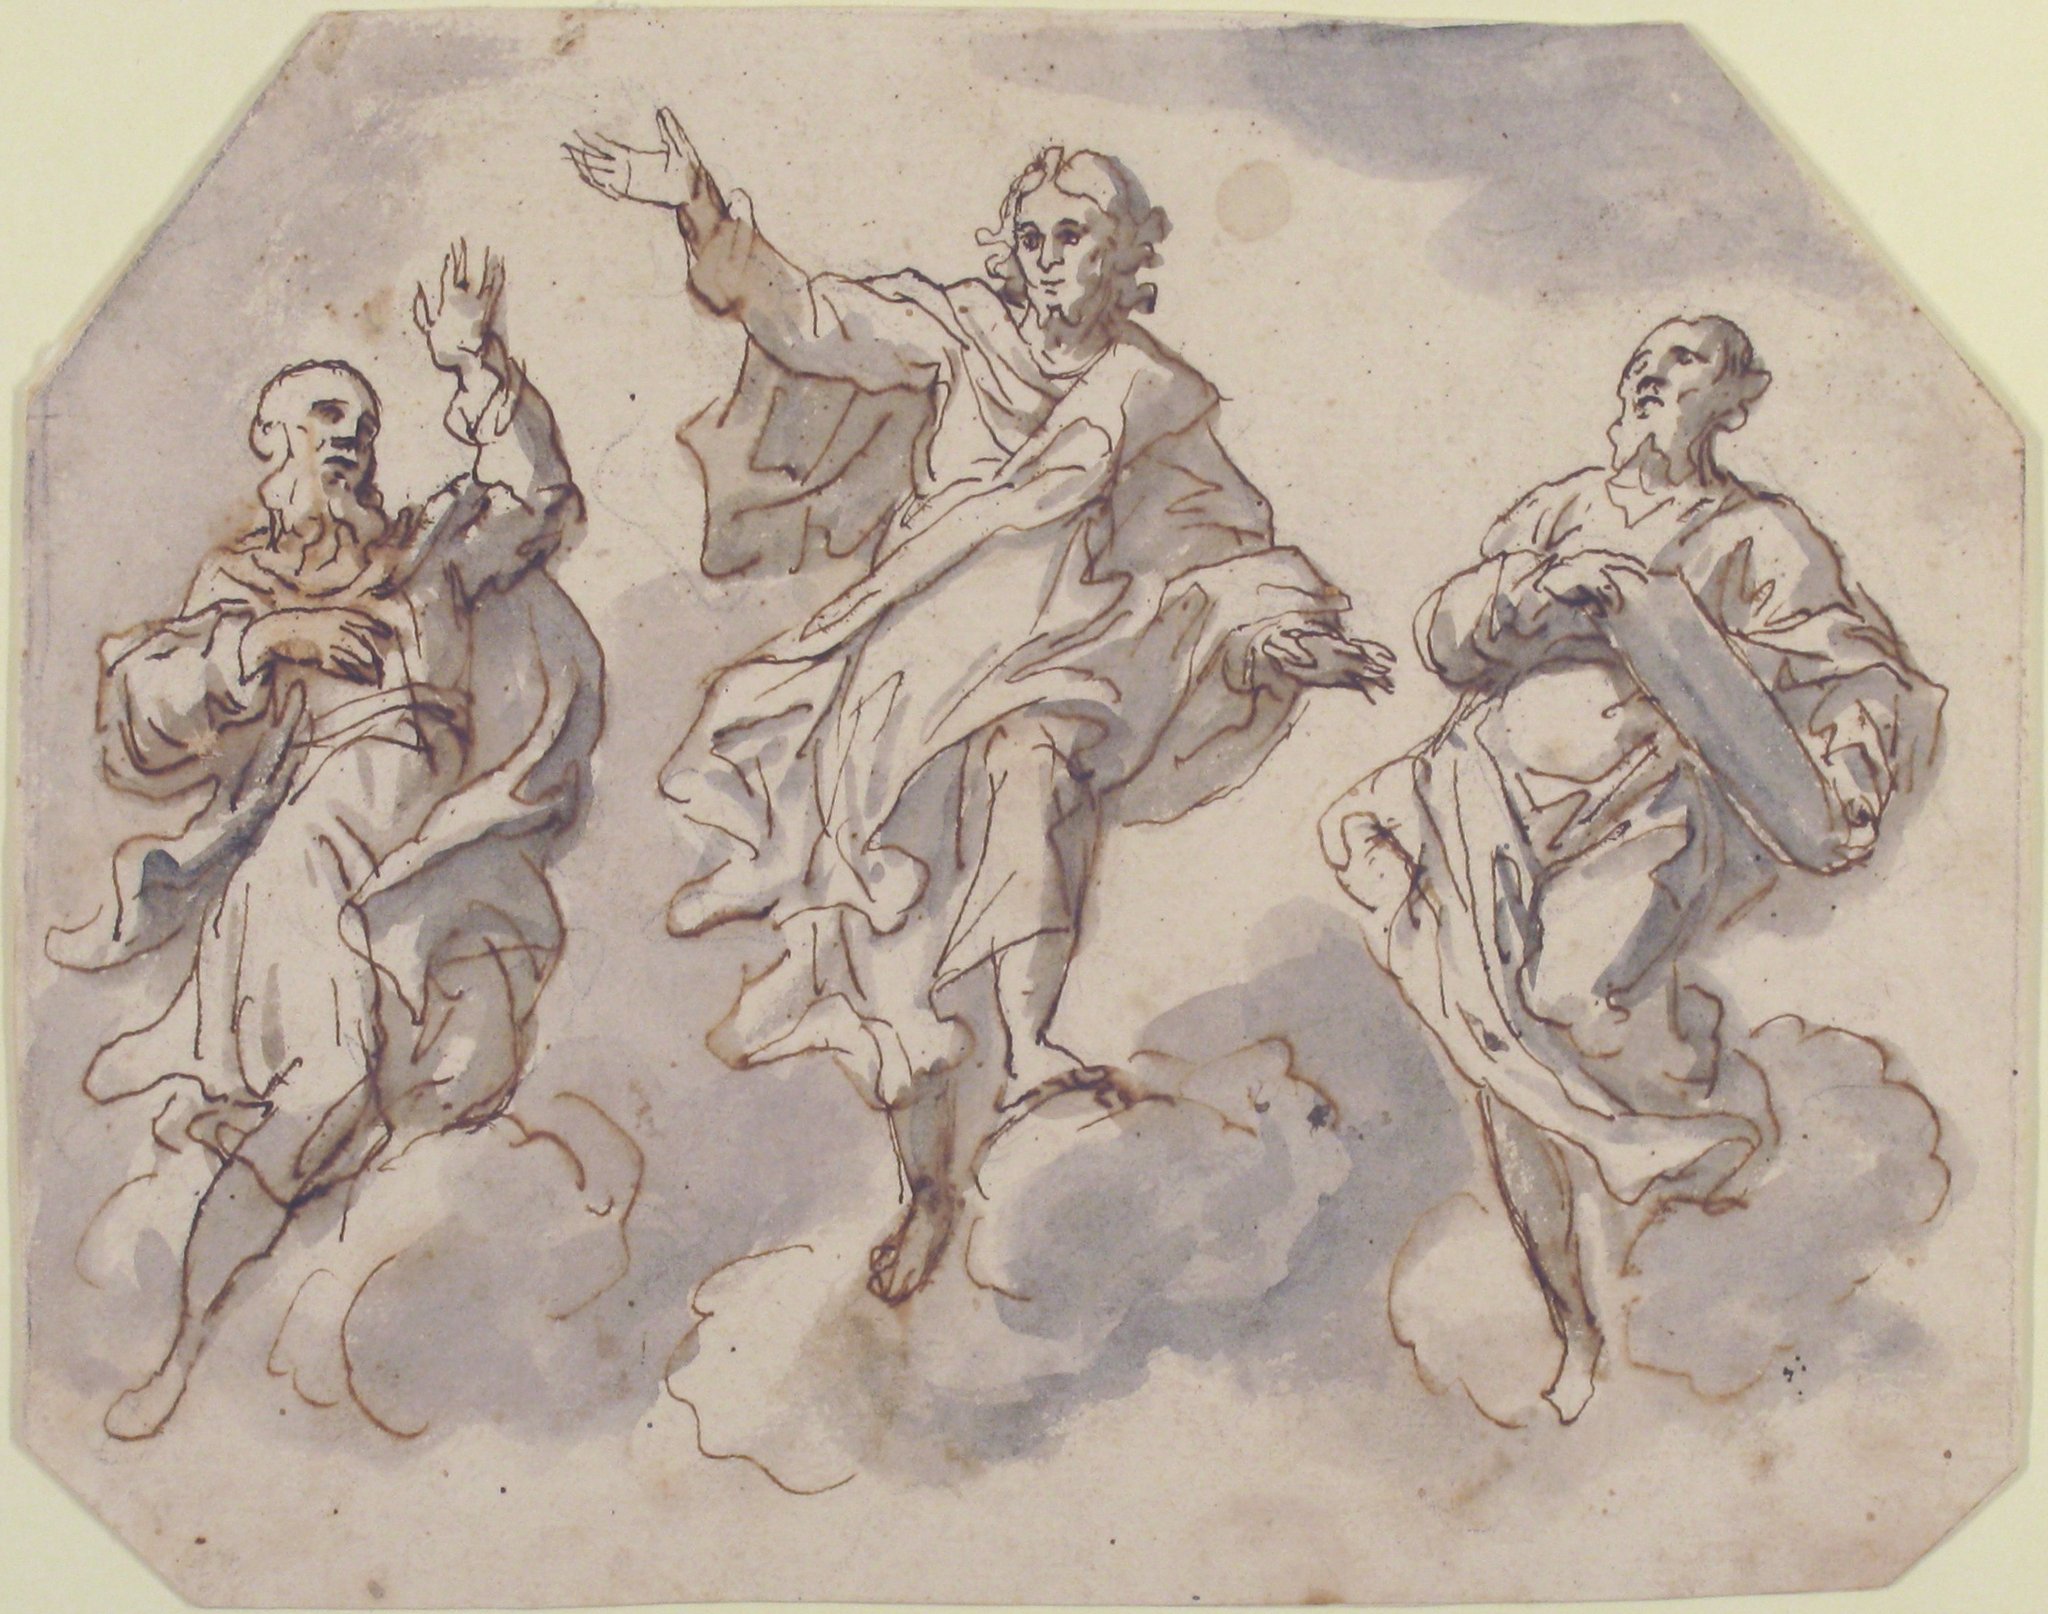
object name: drawing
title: The Transfiguration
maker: francesco curia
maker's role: artist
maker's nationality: italian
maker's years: 1565-1608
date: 1565-1608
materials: ink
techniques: brush, pen, wash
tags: men